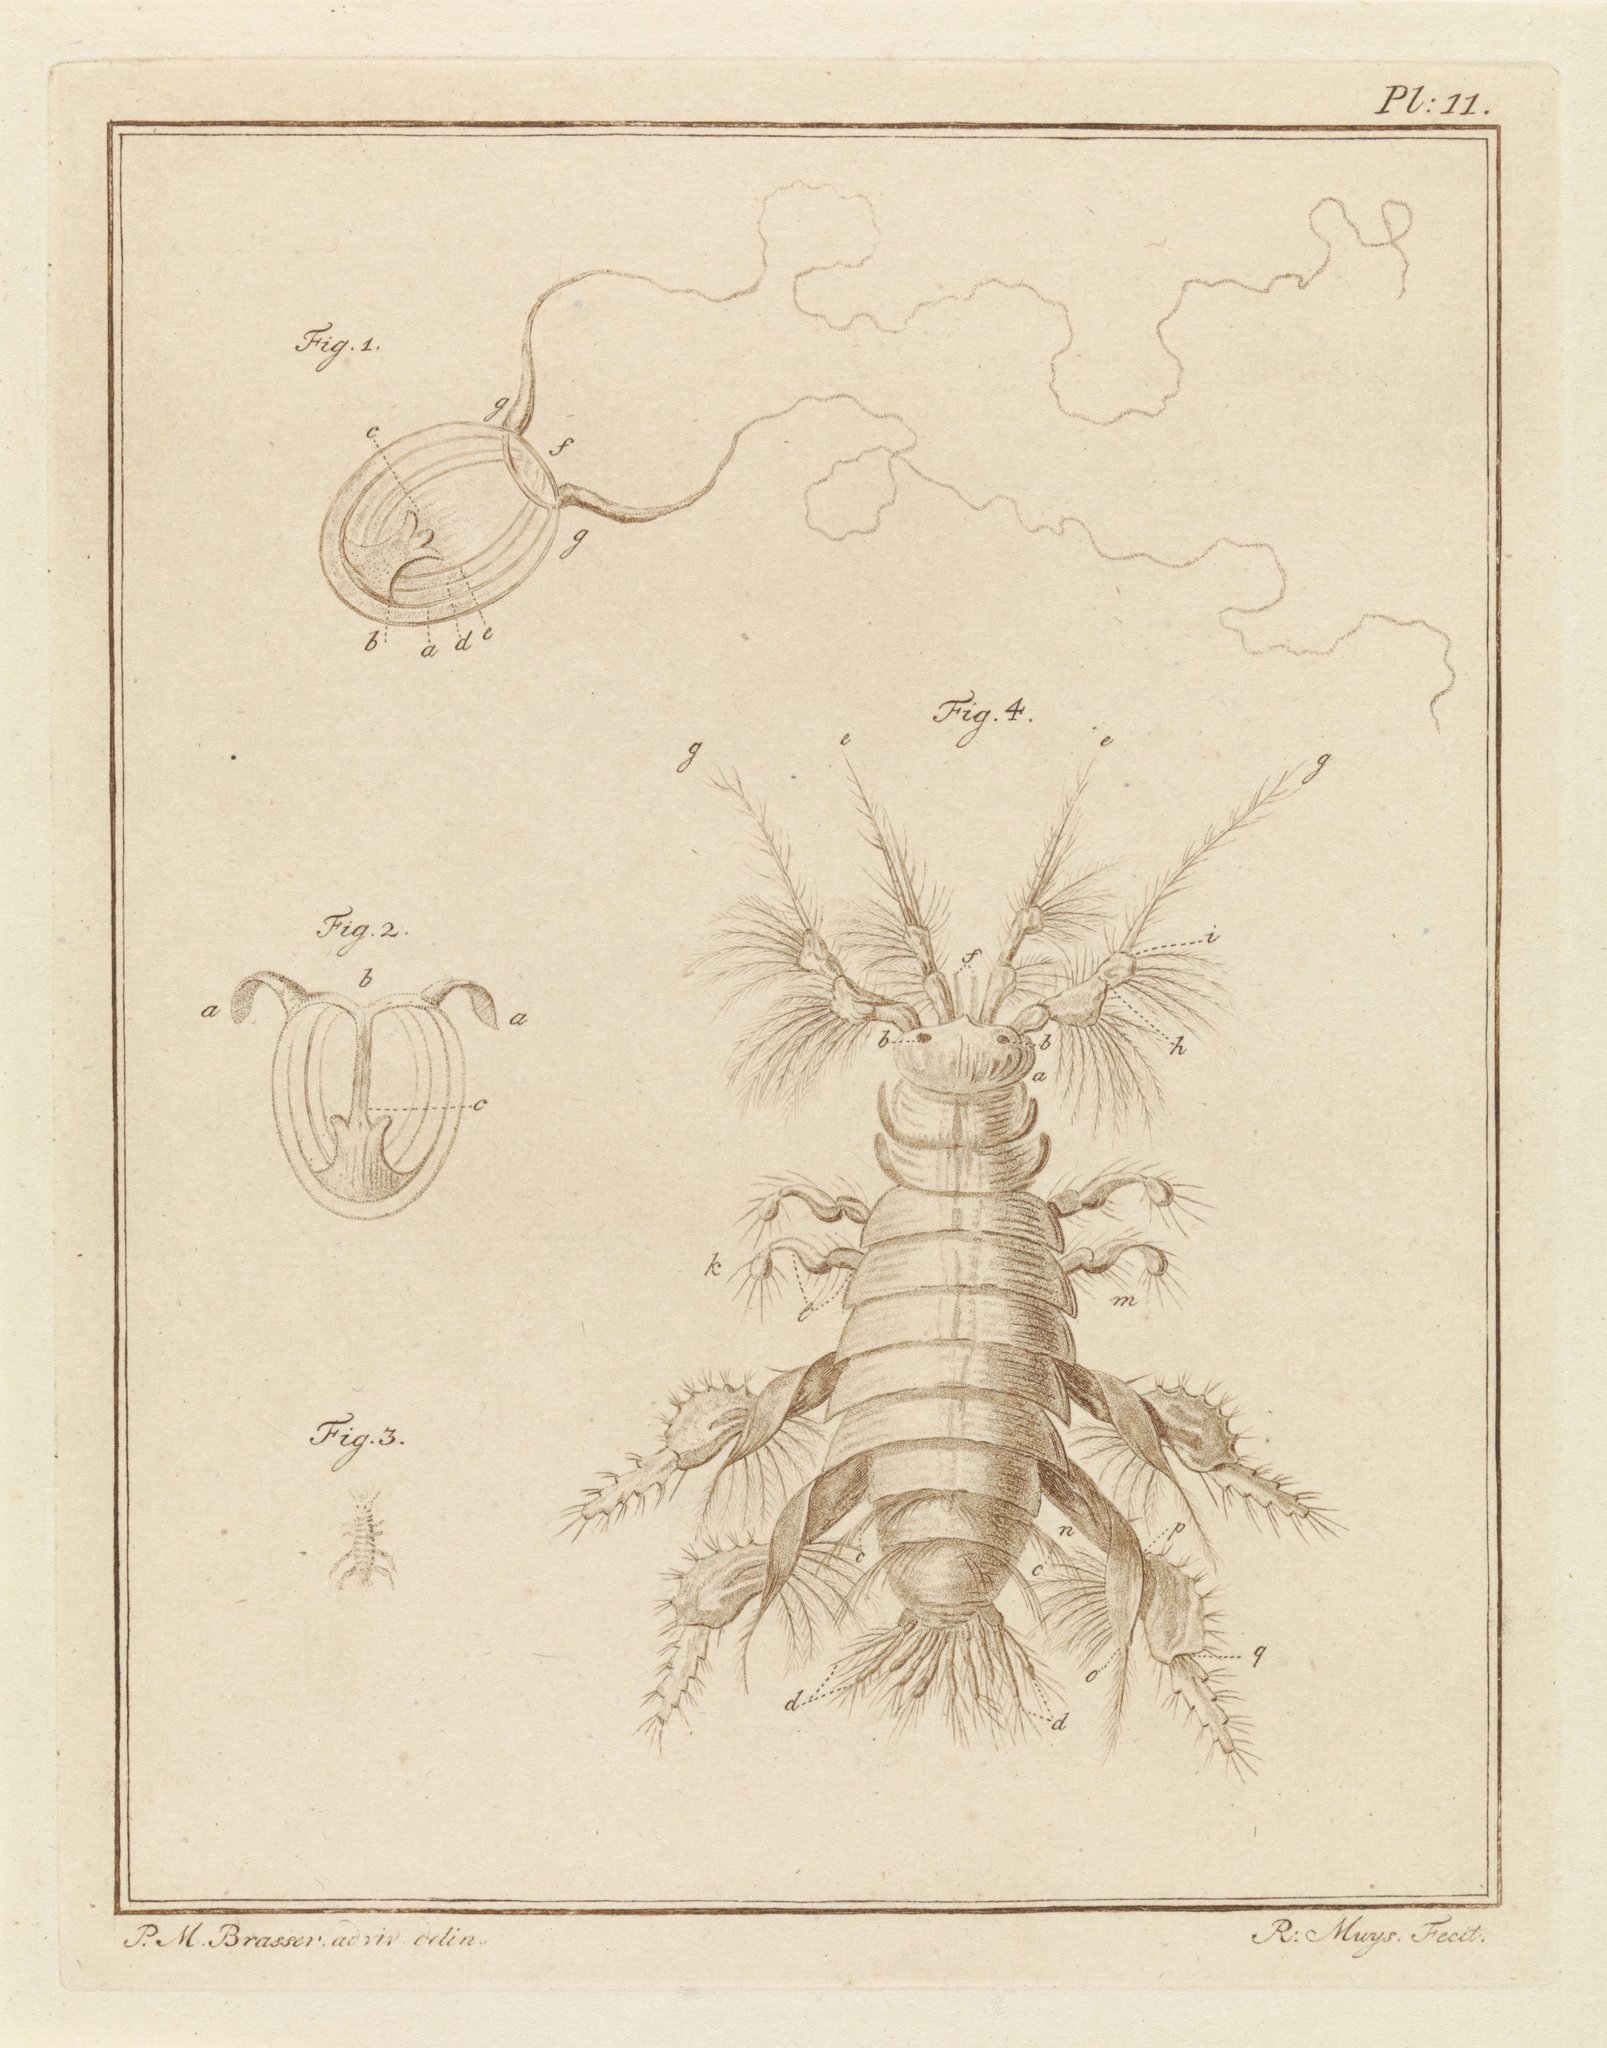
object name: print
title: Poliepkwalletje en een zandvlokkreeft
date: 1778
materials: paper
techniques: etching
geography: rotterdam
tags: lower animals (+ animals ~ biological investigation)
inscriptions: collector's mark: Lugt 2228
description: Zeedieren. Figuur 1 en 2 tonen een poliepkwalletje. Figuur 3 en 4 tonen een zandvlokkreeft op ware grootte en uitvergroot. Rechtsboven: Pl. 11. Prent uit een boek over binnen- en buitenlandse land- en waterdieren.